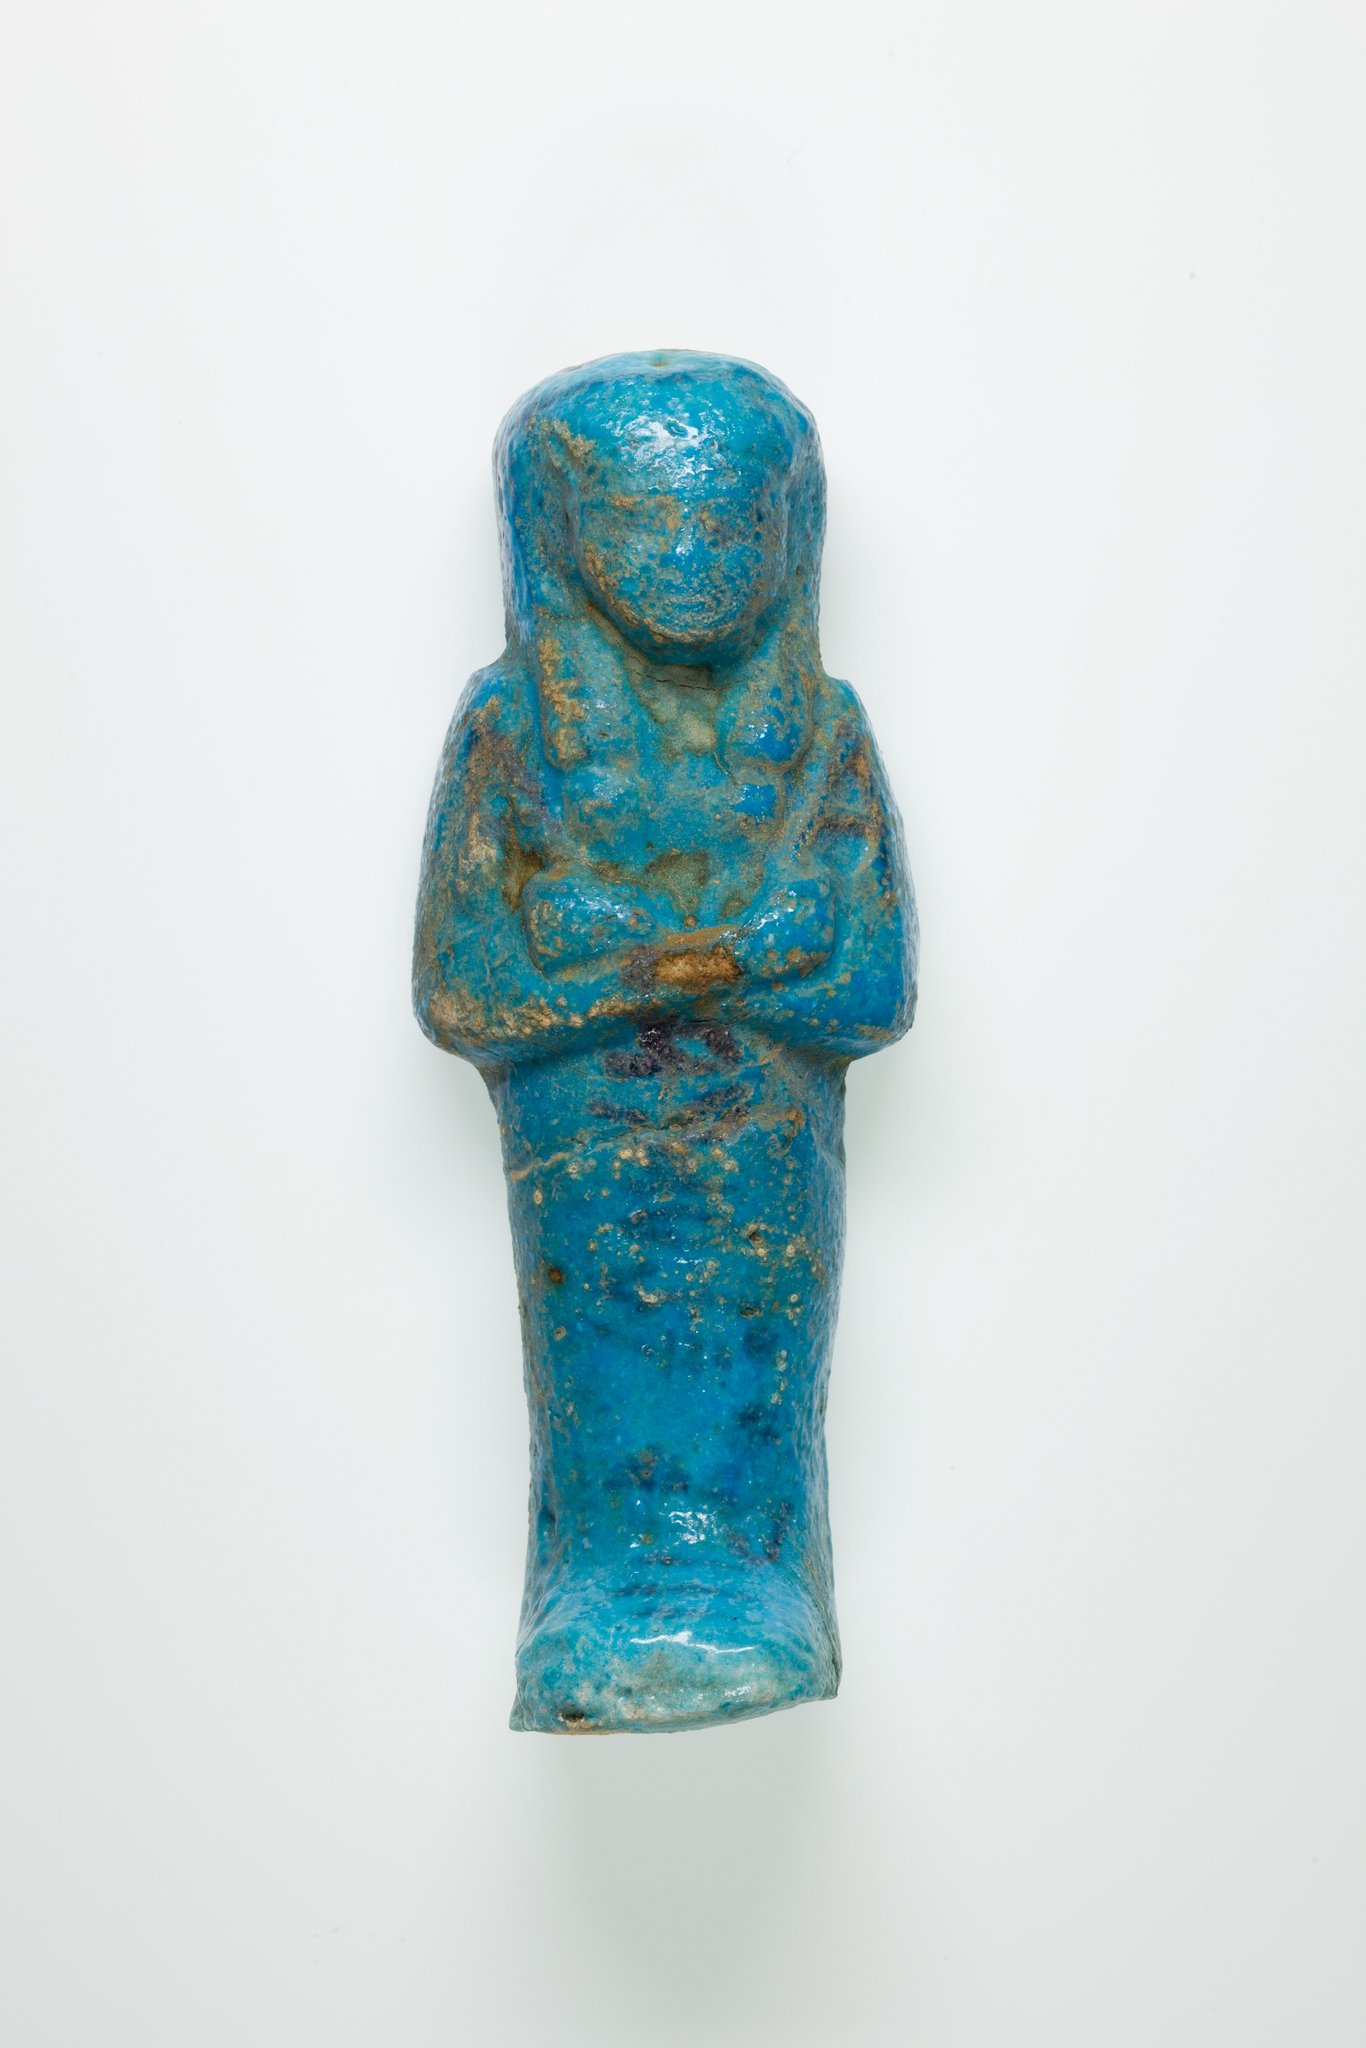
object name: worker shabti, henettawy c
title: Worker Shabti of Henettawy (C), Daughter of Isetemkheb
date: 990-970 BCE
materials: faience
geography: egypt